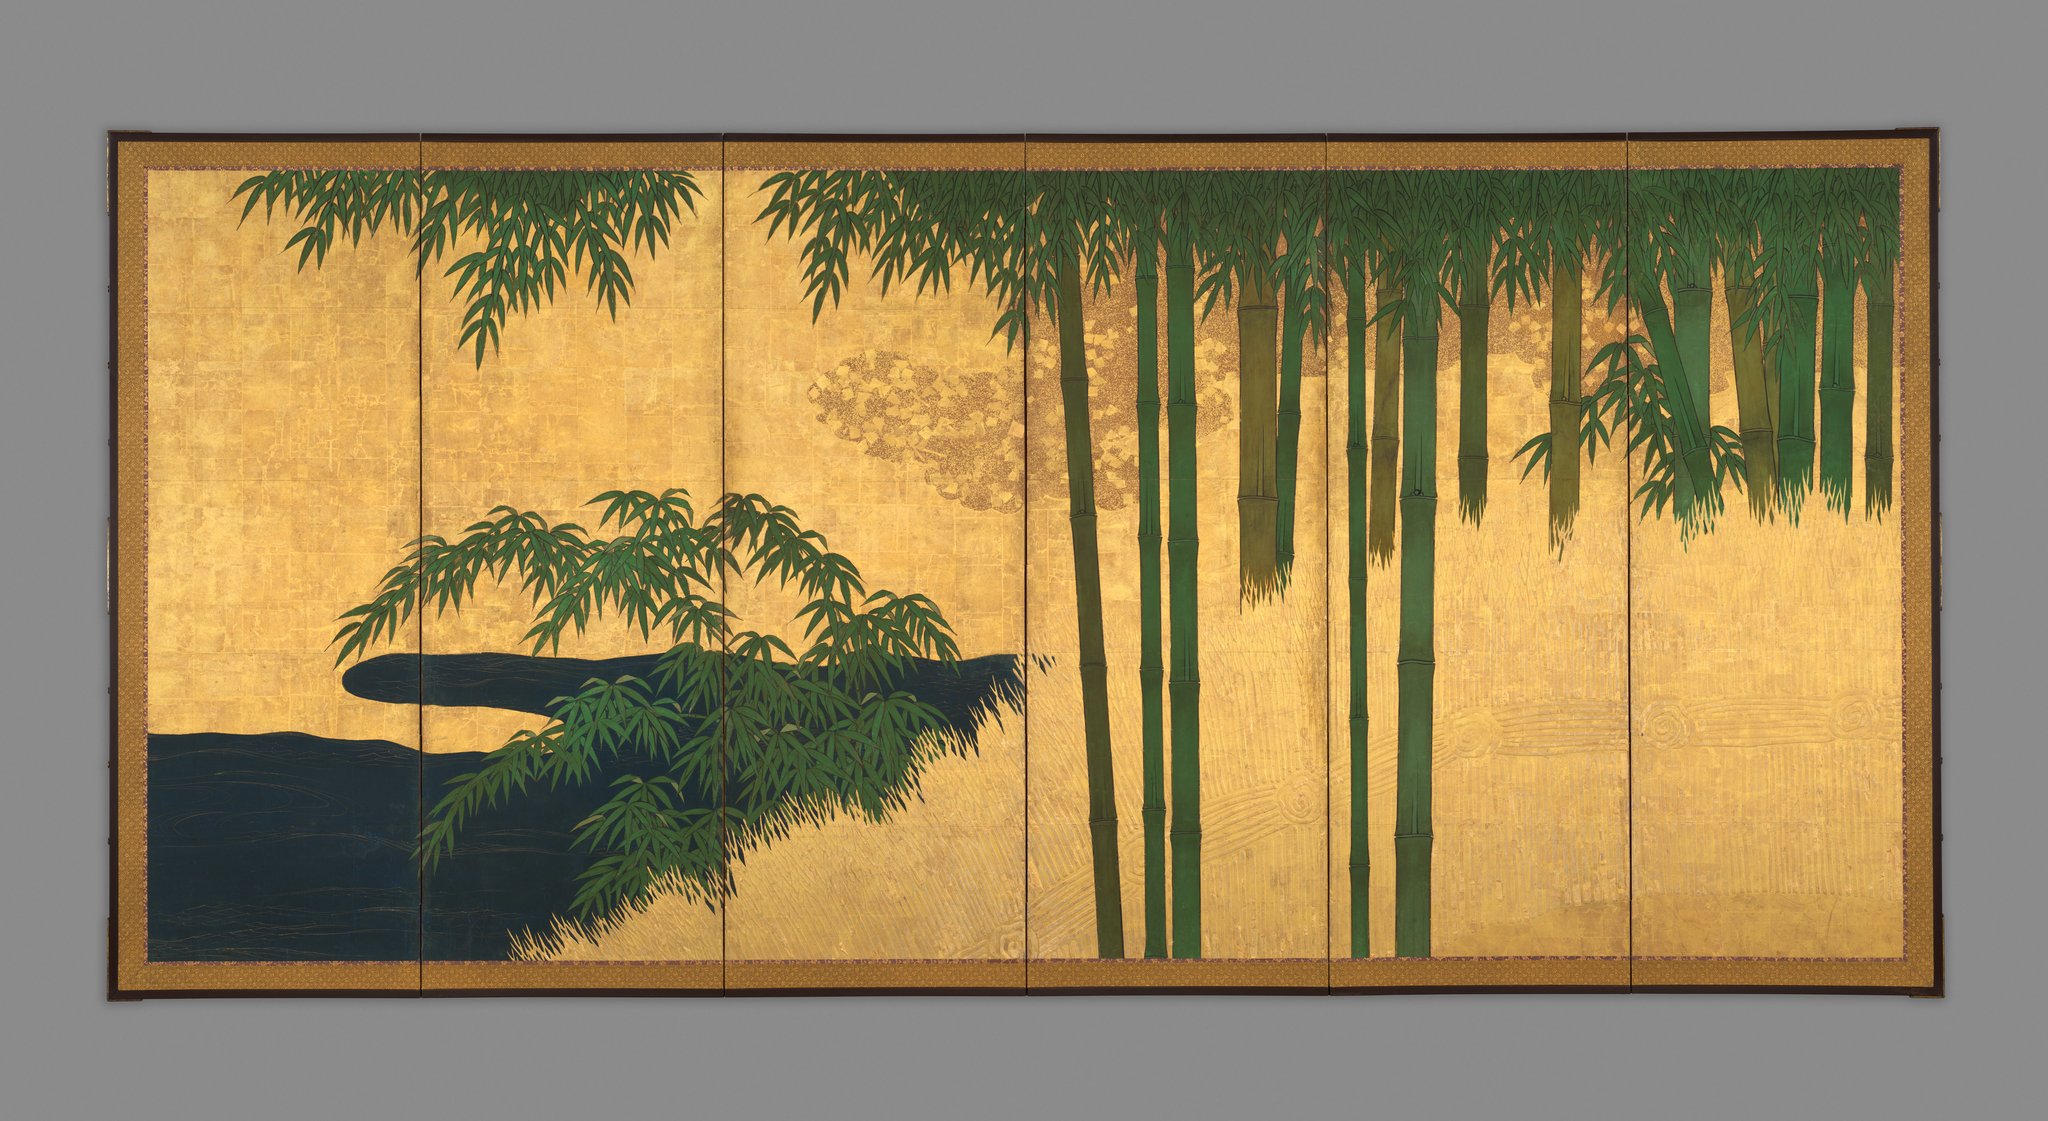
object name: screen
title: Bamboo Grove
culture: japanese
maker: unidentified artist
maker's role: artist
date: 1651-1700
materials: gold, gold leaf, ink, panel, paper